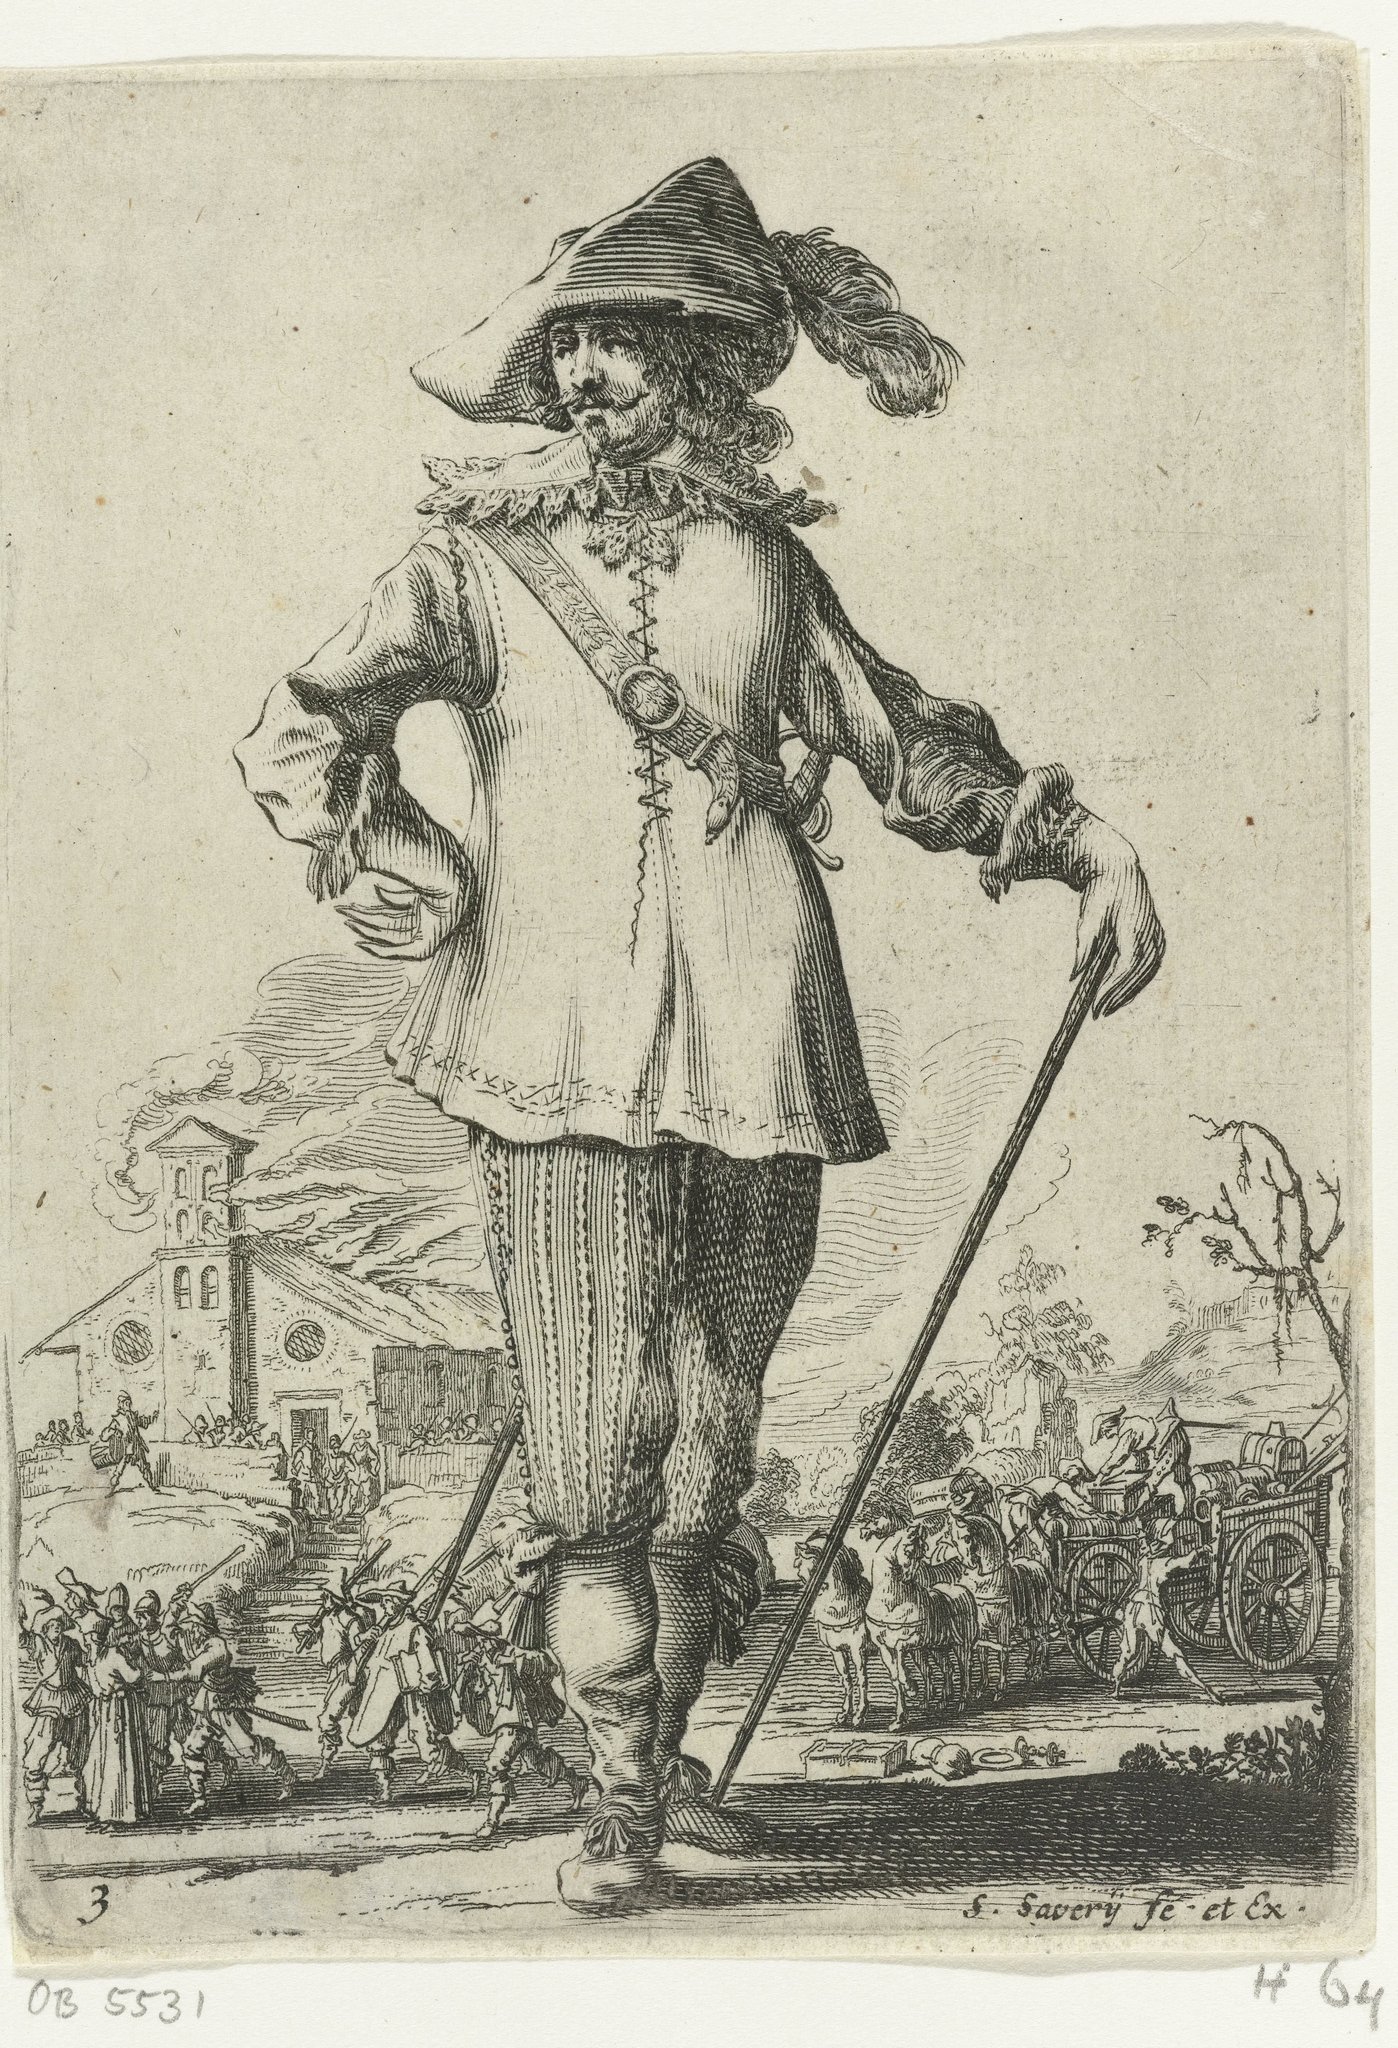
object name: costume print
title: Staande officier met wandelstok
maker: salomon savery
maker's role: print maker, publisher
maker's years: 1594-1683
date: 1630-1665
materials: paper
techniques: engraving, etching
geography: amsterdam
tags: walking-stick, staff, clothes, costume (+ men's clothes), officer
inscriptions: collector's mark: Lugt 240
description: Officier, van voren gezien, met in zijn linkerhand een wandelstok. Op de achtergrond een brandende kerk en figuren. De prent maakt deel uit van een tiendelige serie met voorstellingen van gewapende officieren en soldaten, gekleed volgens de Nederlandse mode ca. 1625-1635.